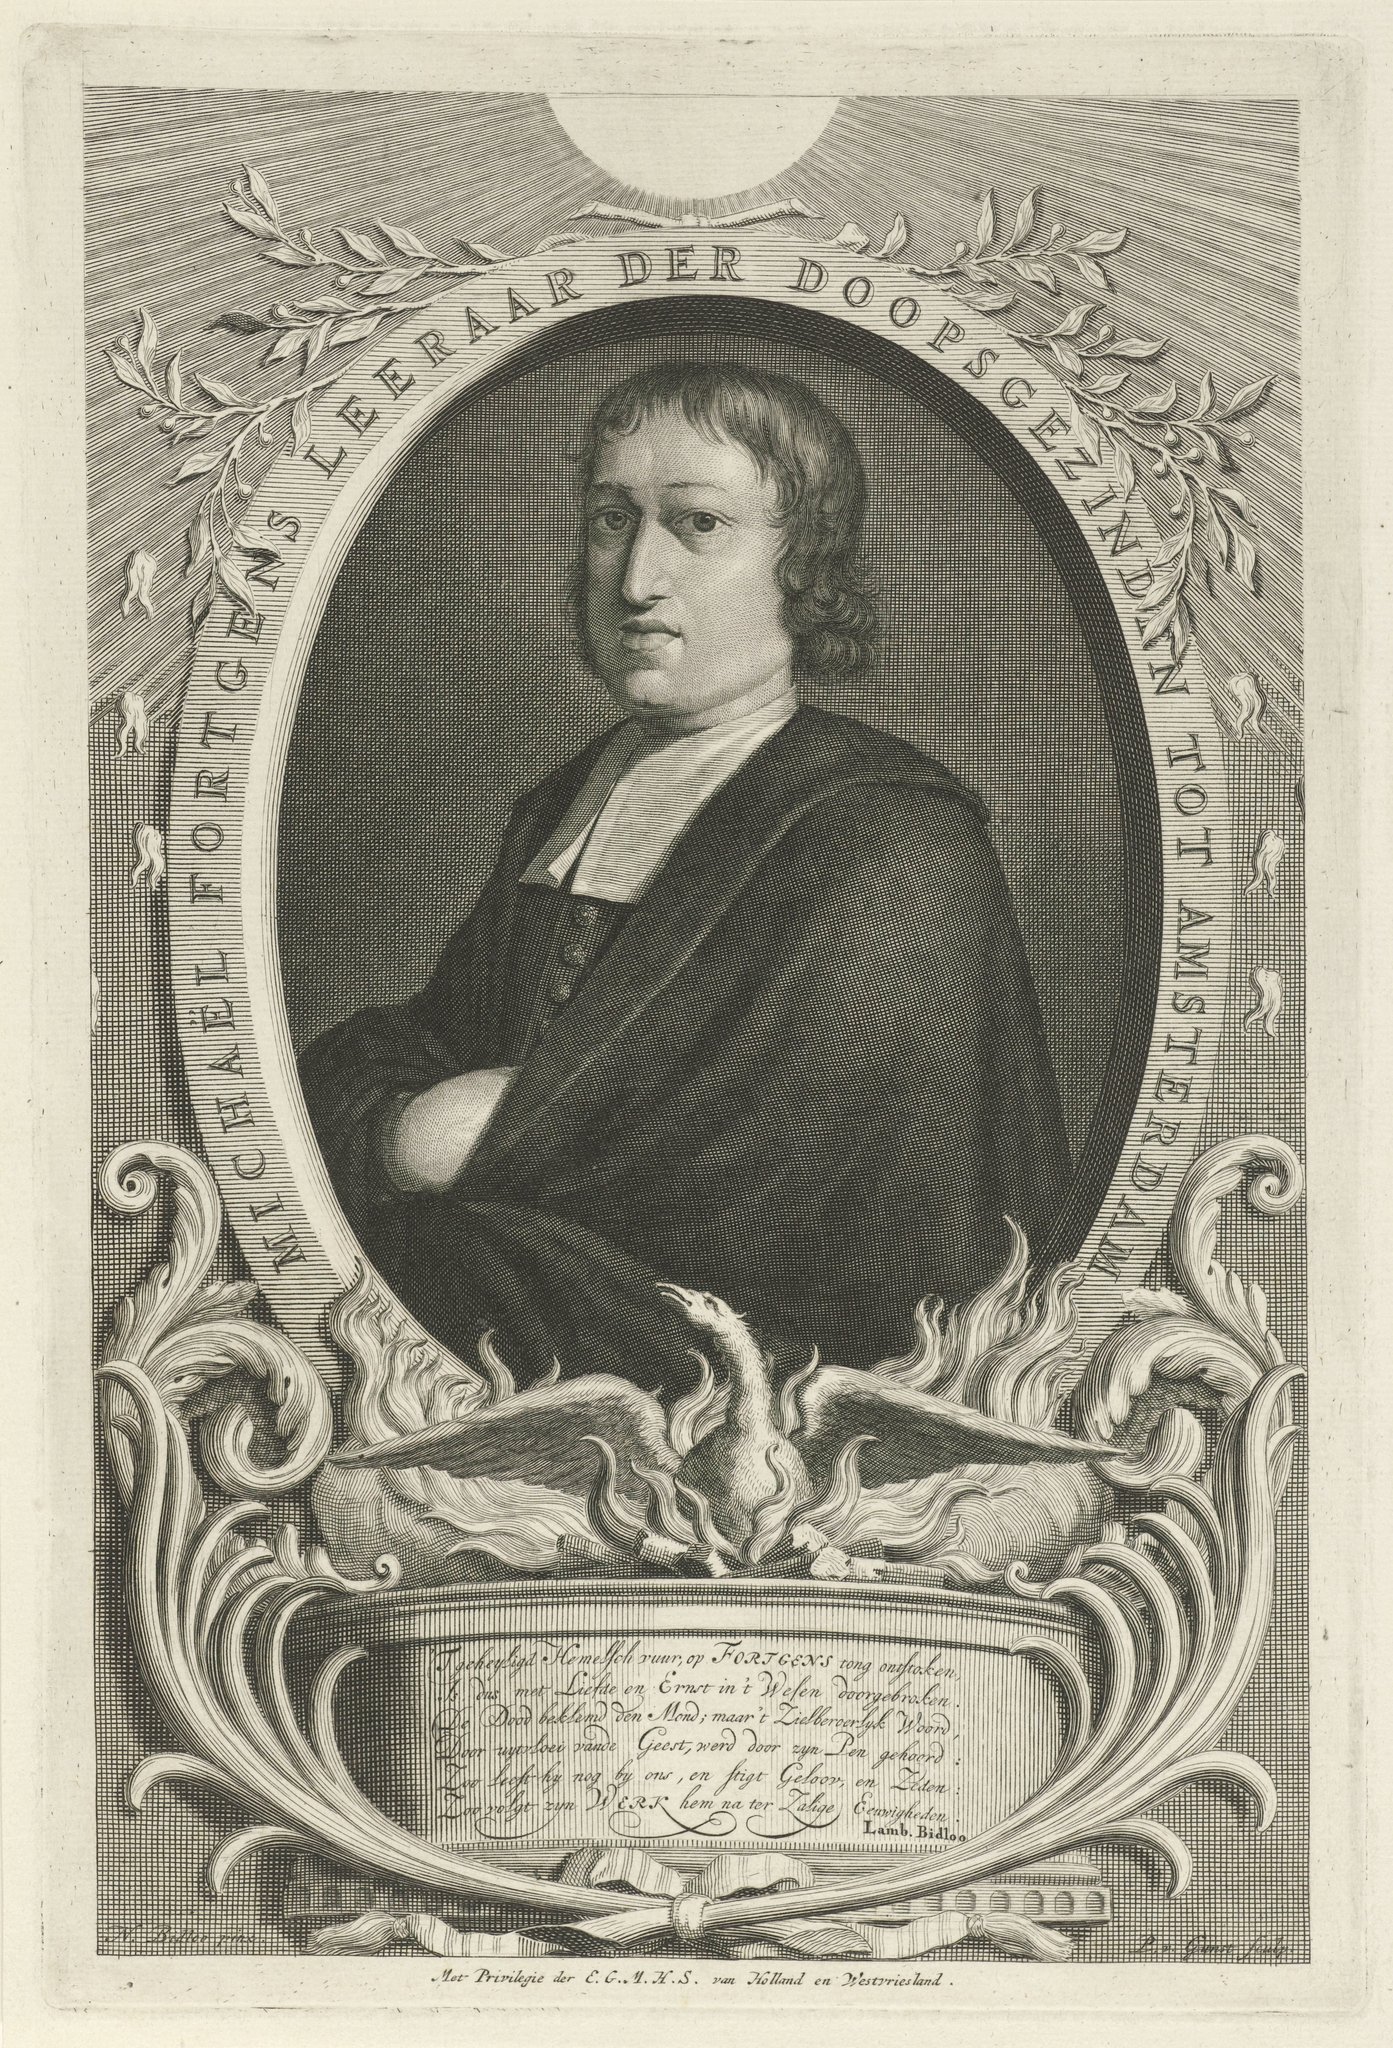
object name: print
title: Portret van Michael Fortgens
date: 1695-1731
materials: paper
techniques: engraving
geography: amsterdam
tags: (story of) phoenix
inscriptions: collector's mark: Lugt 240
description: Michael Fortgens, Amsterdams predikant en leraar van de doopsgezinde gemeente aldaar. Onder het portret een feniks en een Nederlands gedicht over zijn leven.